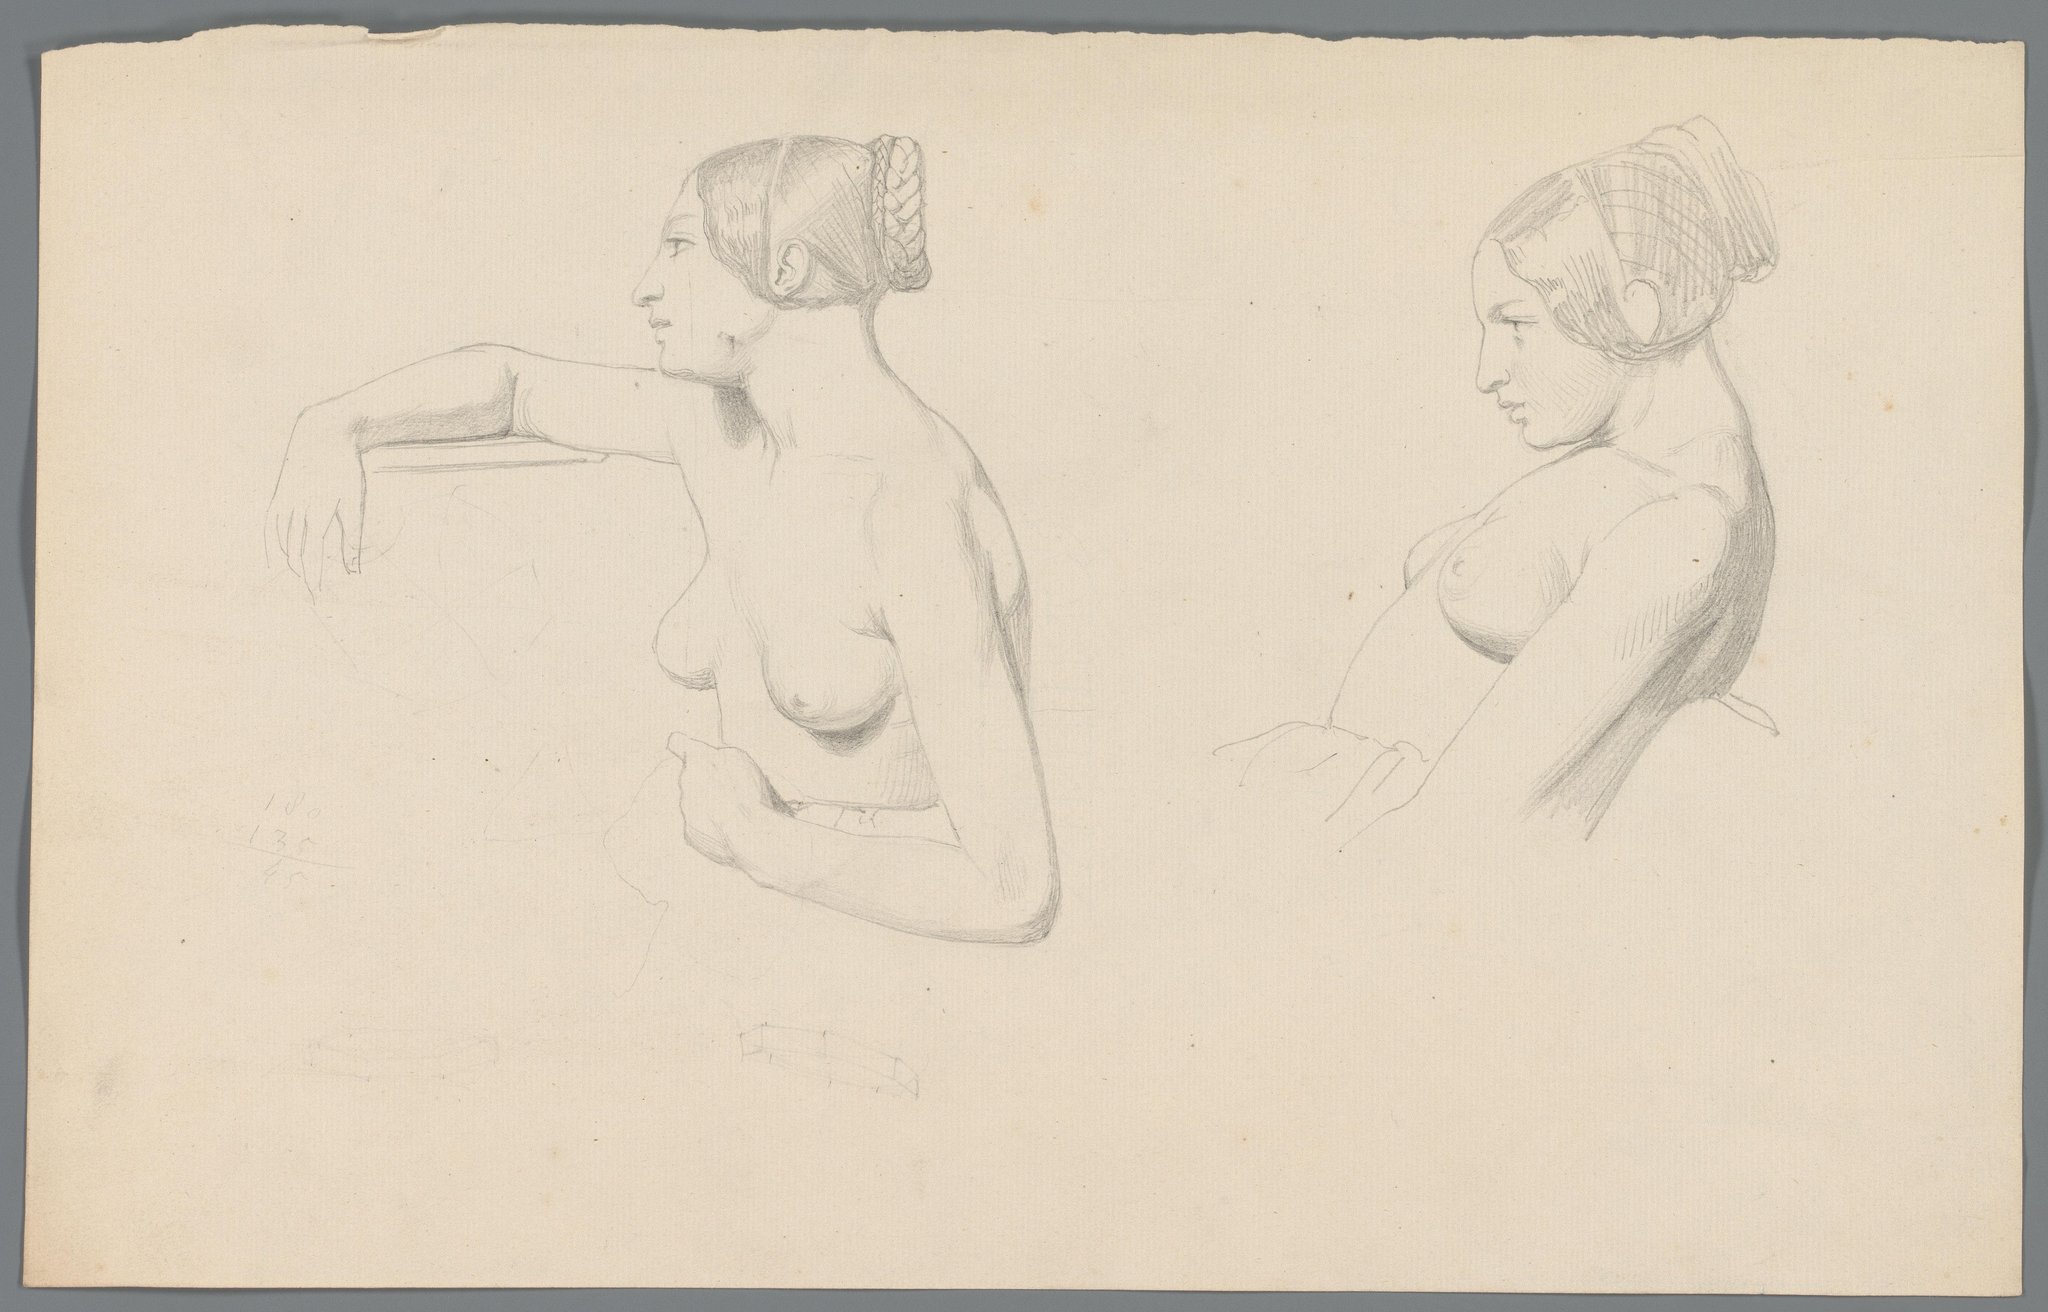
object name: drawing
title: Studie van een vrouw met ontbloot bovenlijf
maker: jacobus everhardus josephus van den berg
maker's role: draughtsman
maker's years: 1802-1861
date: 1812-1861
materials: paper, pencil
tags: the (nude) human figure; 'corpo humano' (ripa) - aa - female human figure, chest, bust - aa - female human figure